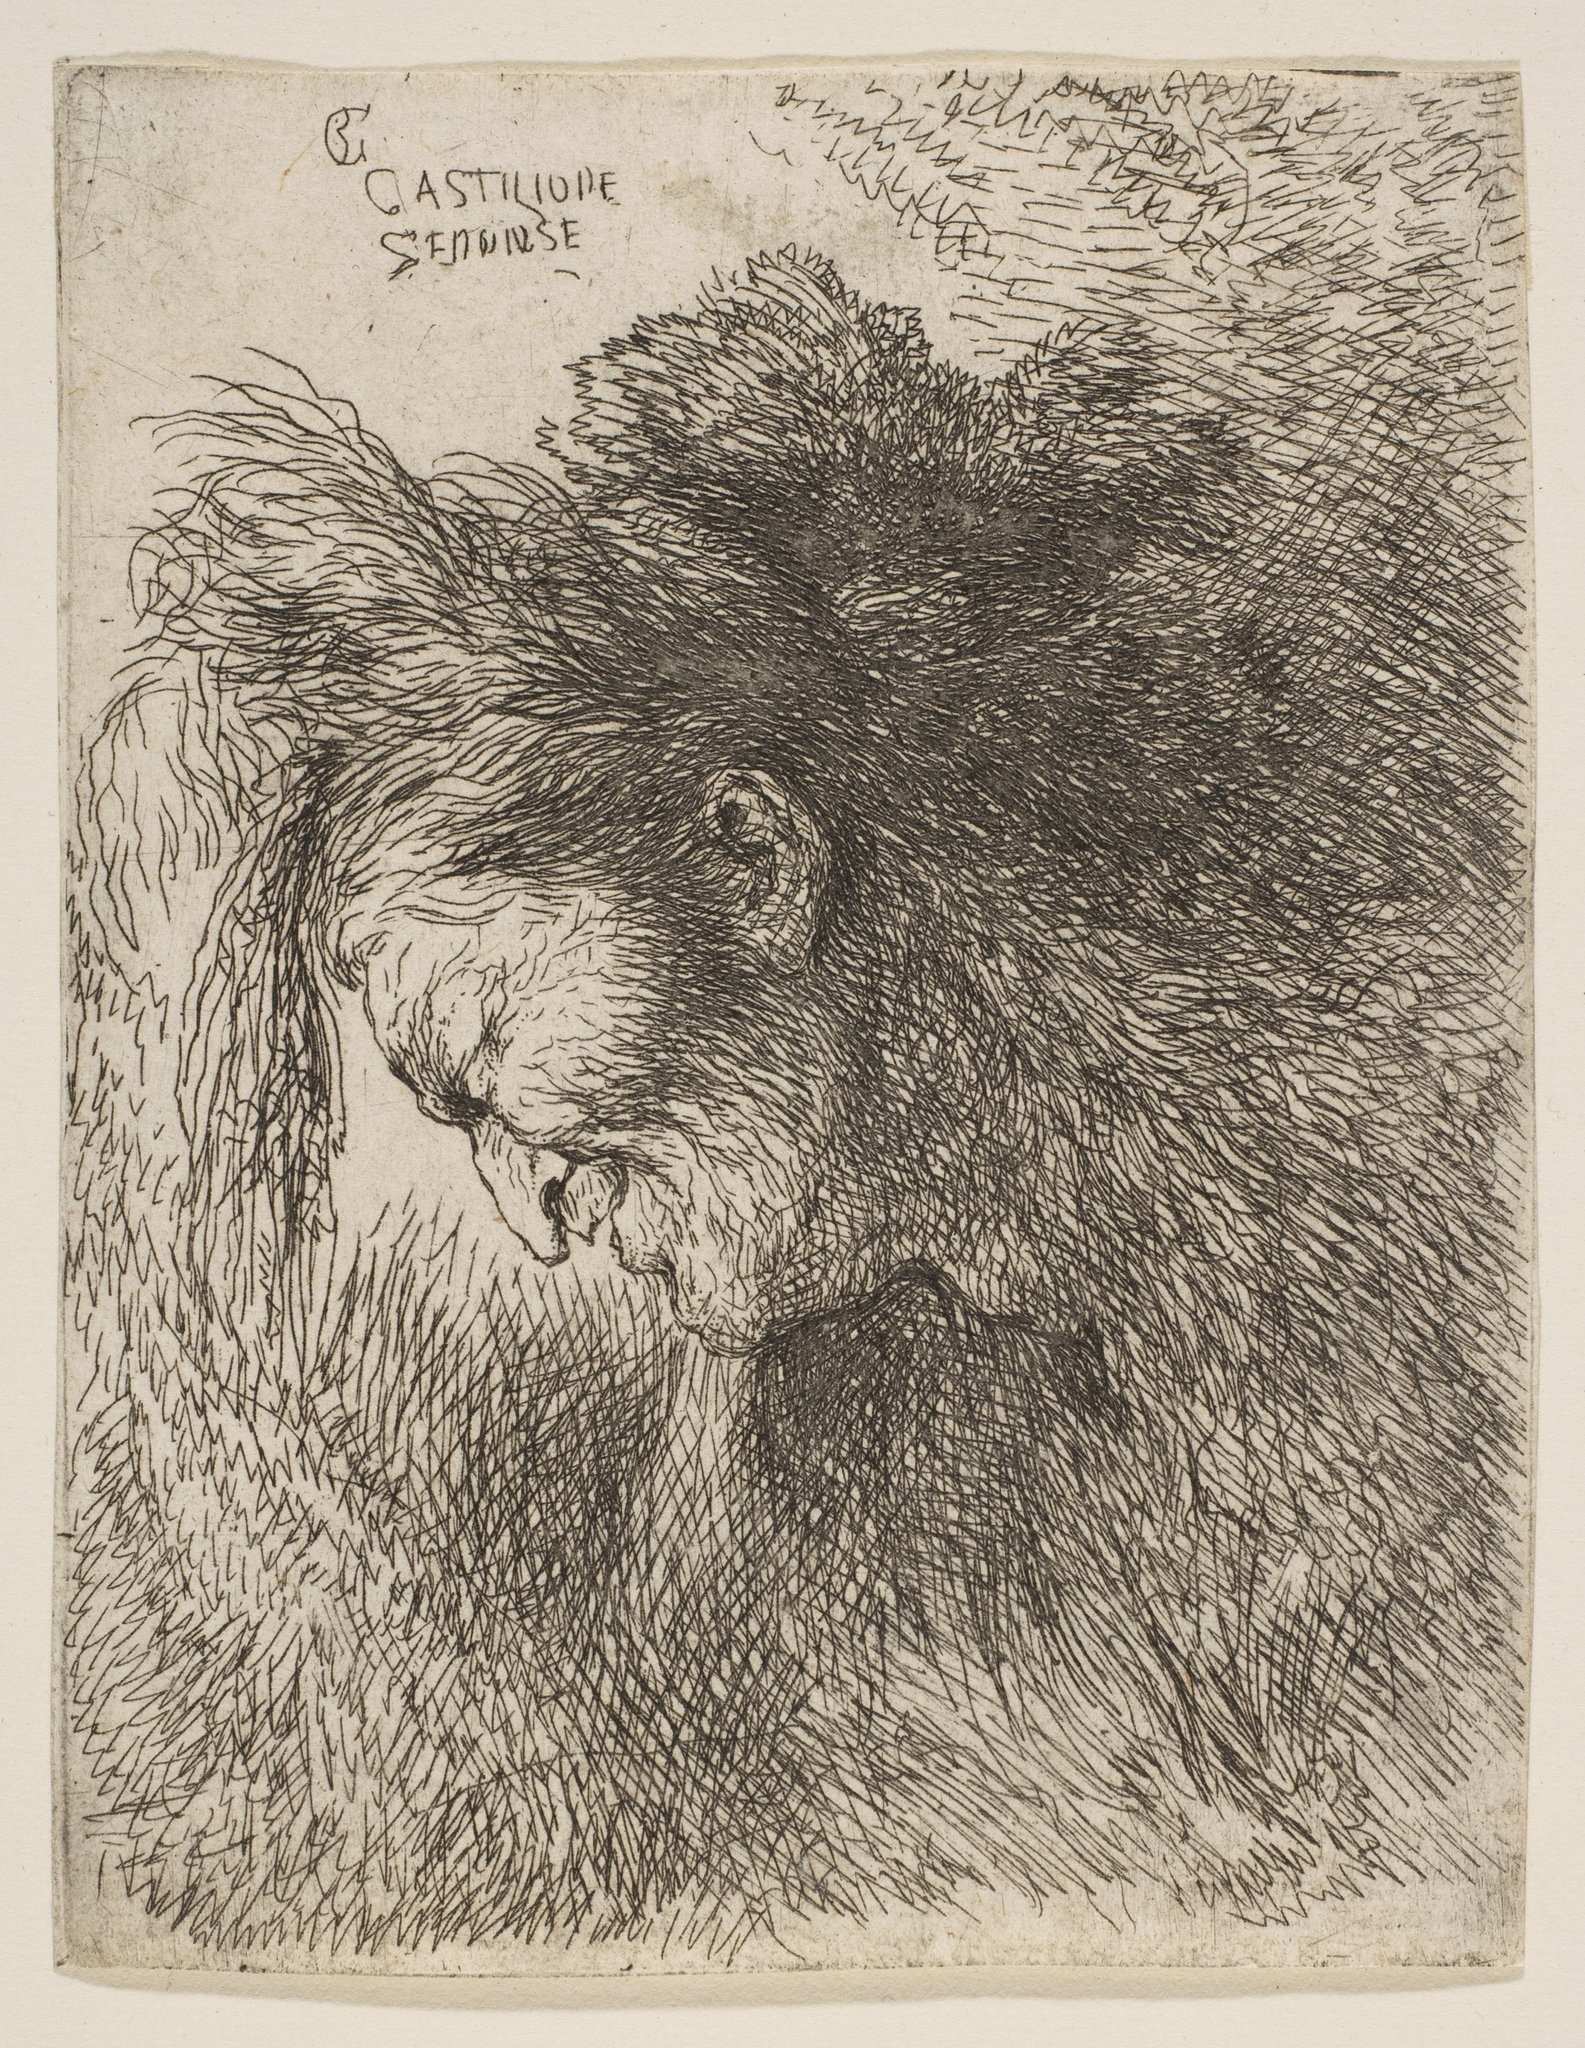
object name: print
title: Head of an old man looking down, facing left, from "Small Heads in Oriental Headdress"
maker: giovanni benedetto castiglione (il grechetto)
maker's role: artist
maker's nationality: italian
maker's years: 1609-1664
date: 1645-1650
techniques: etching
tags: heads,men